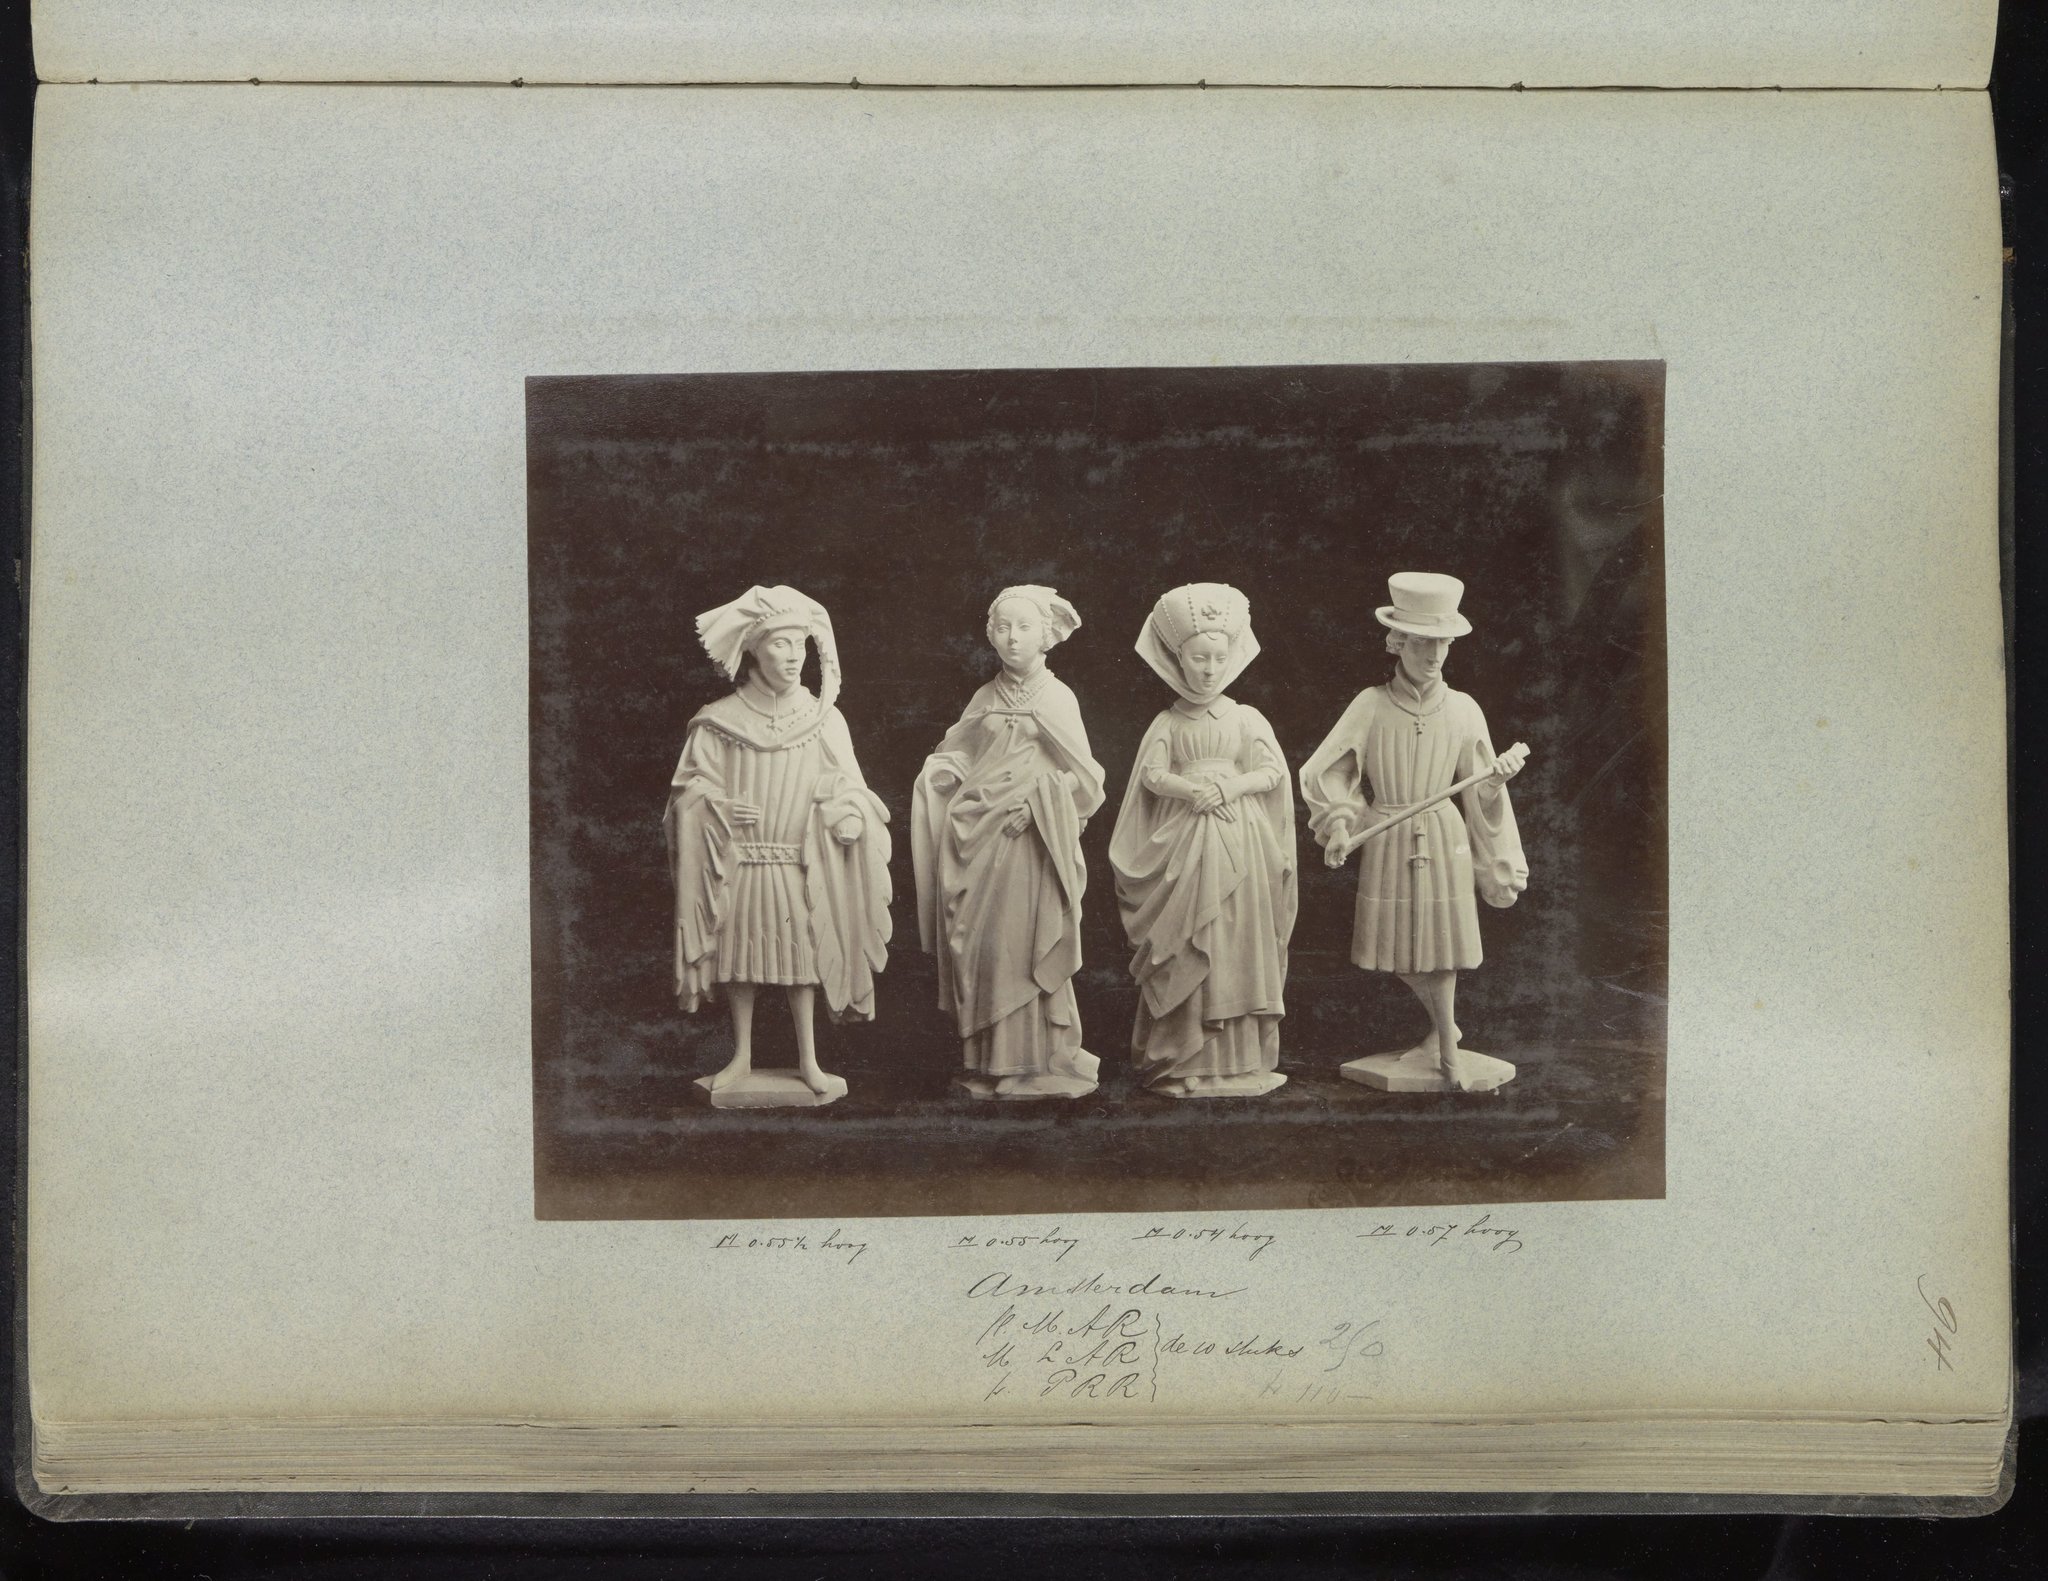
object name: photograph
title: Vier gipsen afgietsels van mensfiguren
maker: Anonymous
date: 1875-1900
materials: paper, photographic support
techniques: albumen print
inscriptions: annotation: ‘Amsterdam’, annotation, annotation: ‘M 0.55 1/2 hoog M 0.55 hoog M 0.54 hoog M 0.57 hoog’